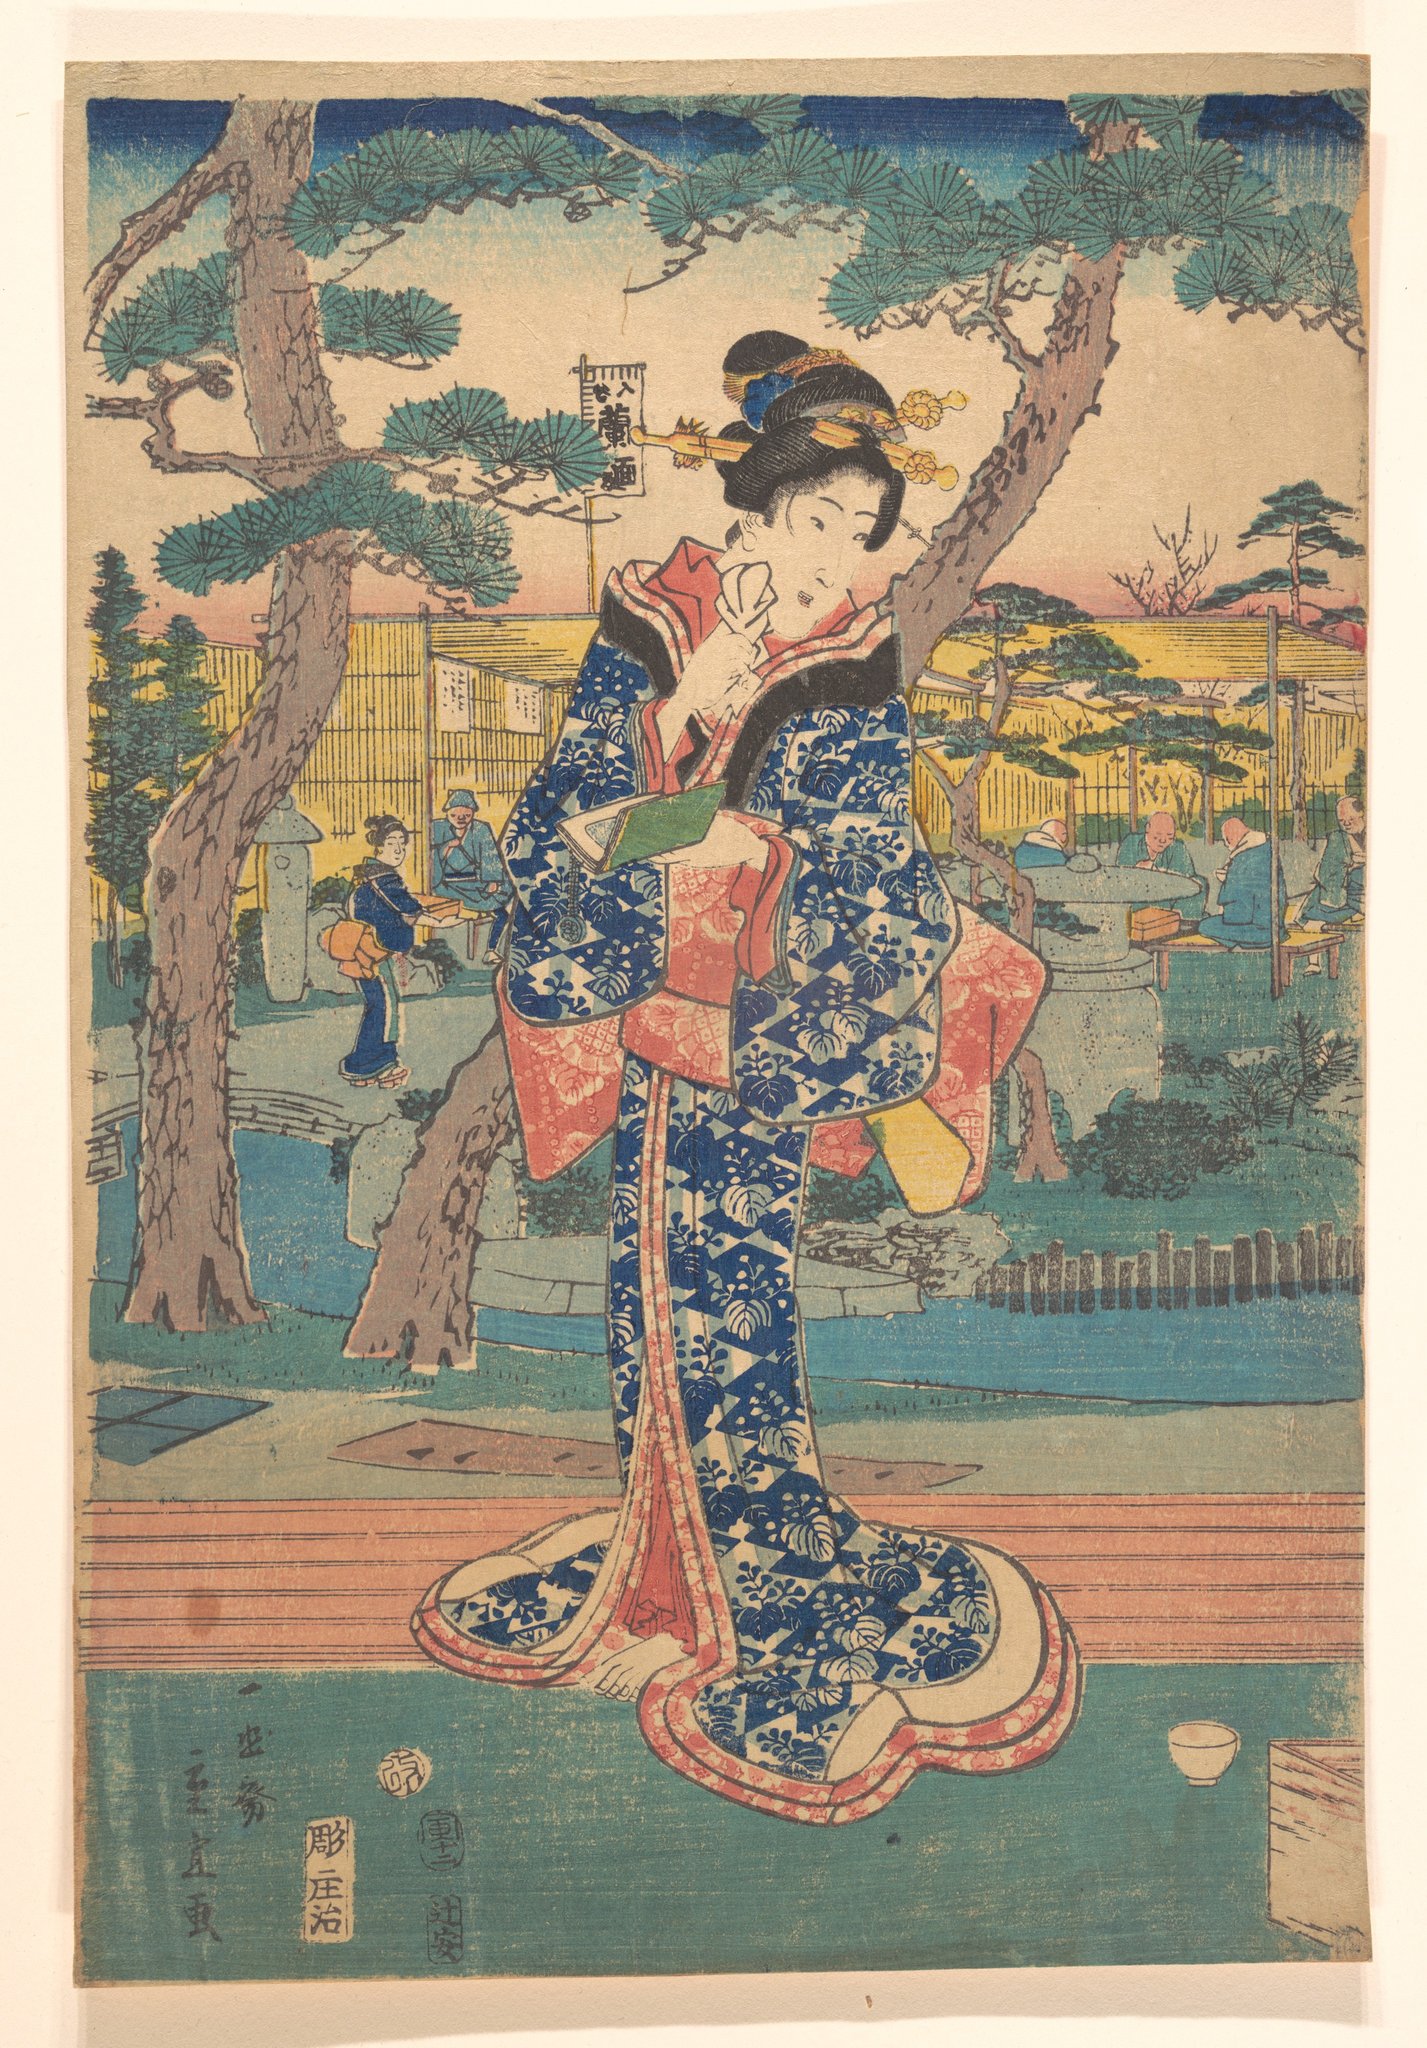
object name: print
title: Young girl at tea house in Iriya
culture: japanese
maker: utagawa hiroshige ii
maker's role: artist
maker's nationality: japanese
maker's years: 1826-1869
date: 1834-1866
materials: ink, paper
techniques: woodblock print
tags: books,men,women,trees